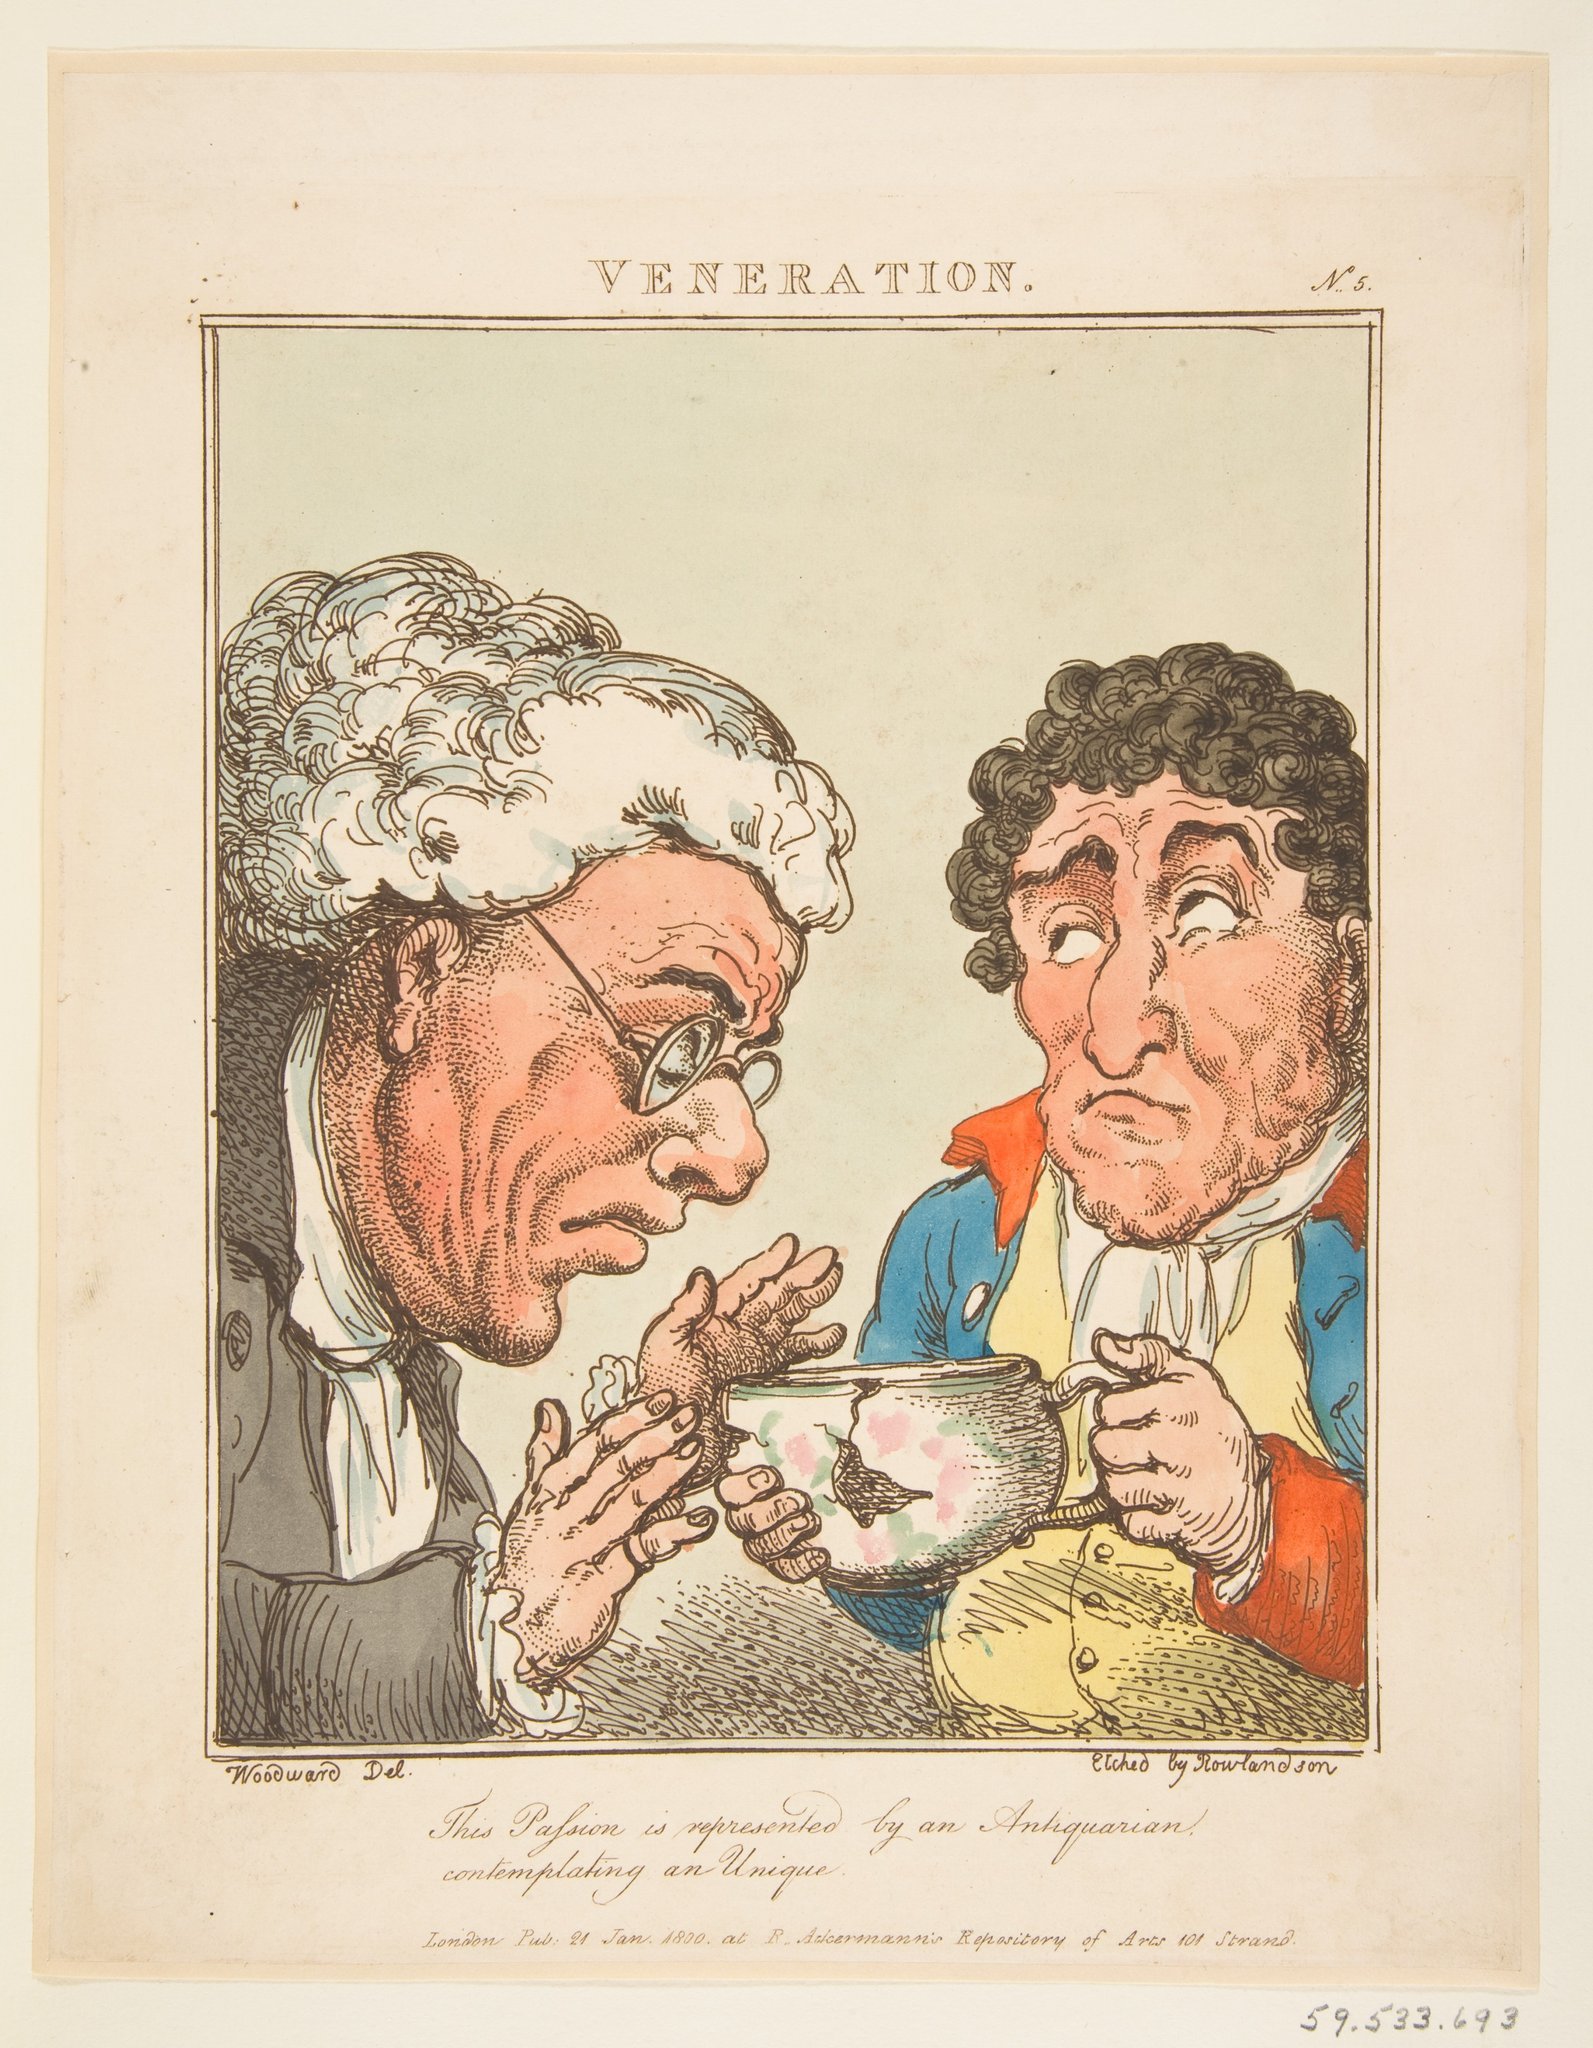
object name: print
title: Veneration (Le Brun Travested, or Caricatures of the Passions)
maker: thomas rowlandson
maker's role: artist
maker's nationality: british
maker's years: 1757-1827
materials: ink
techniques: etching, printing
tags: satire,men